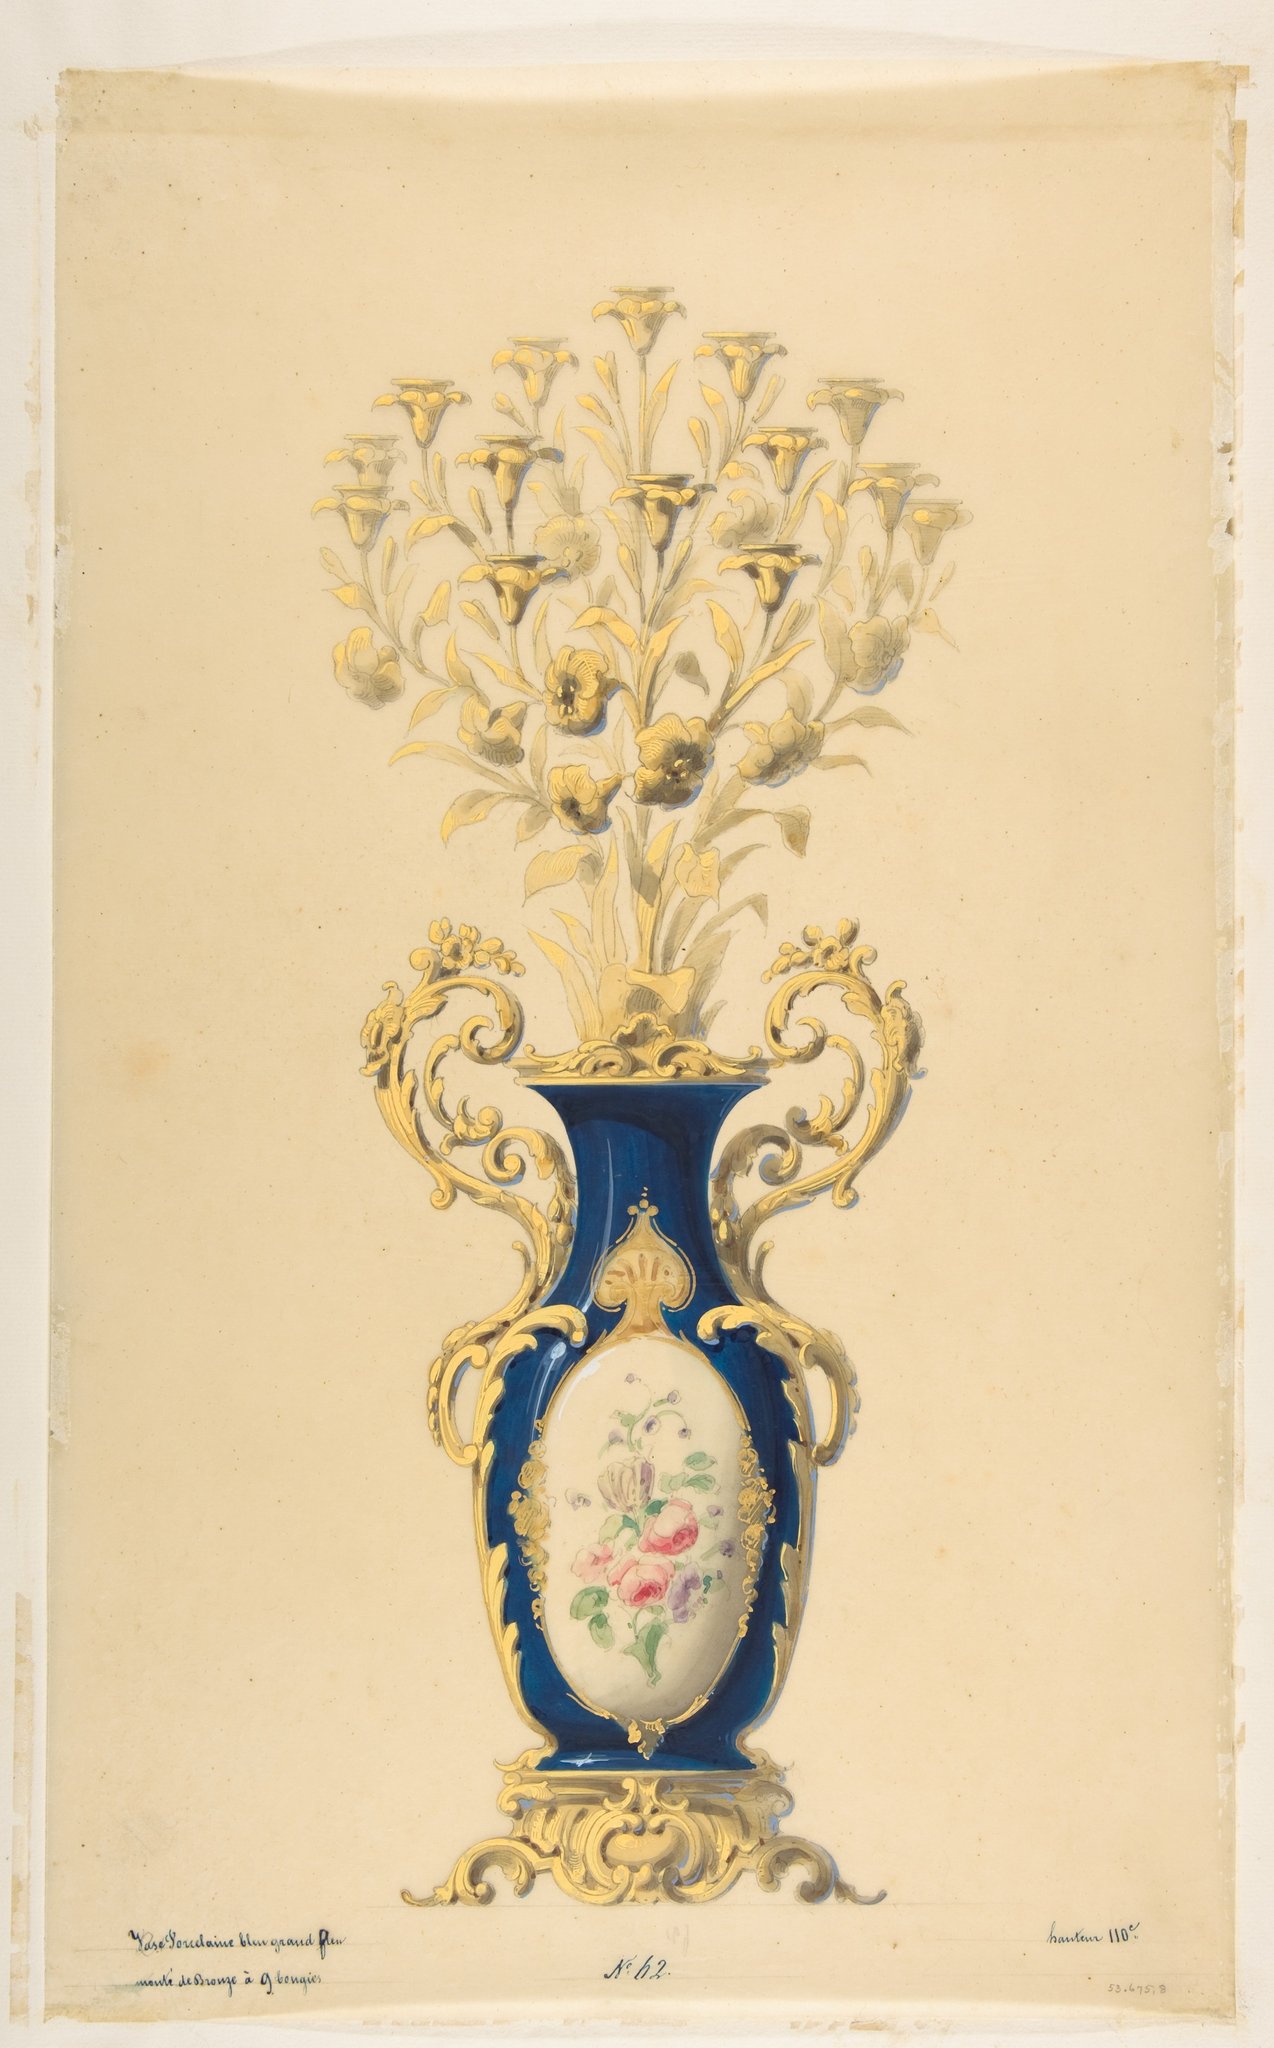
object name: drawing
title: Design for a Porcelain Candelabra with Nine Branches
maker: anonymous, french, 19th century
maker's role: artist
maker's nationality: french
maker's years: 1800-1900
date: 1801-1900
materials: gilt, gold, gouache, graphite, watercolor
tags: candelabra